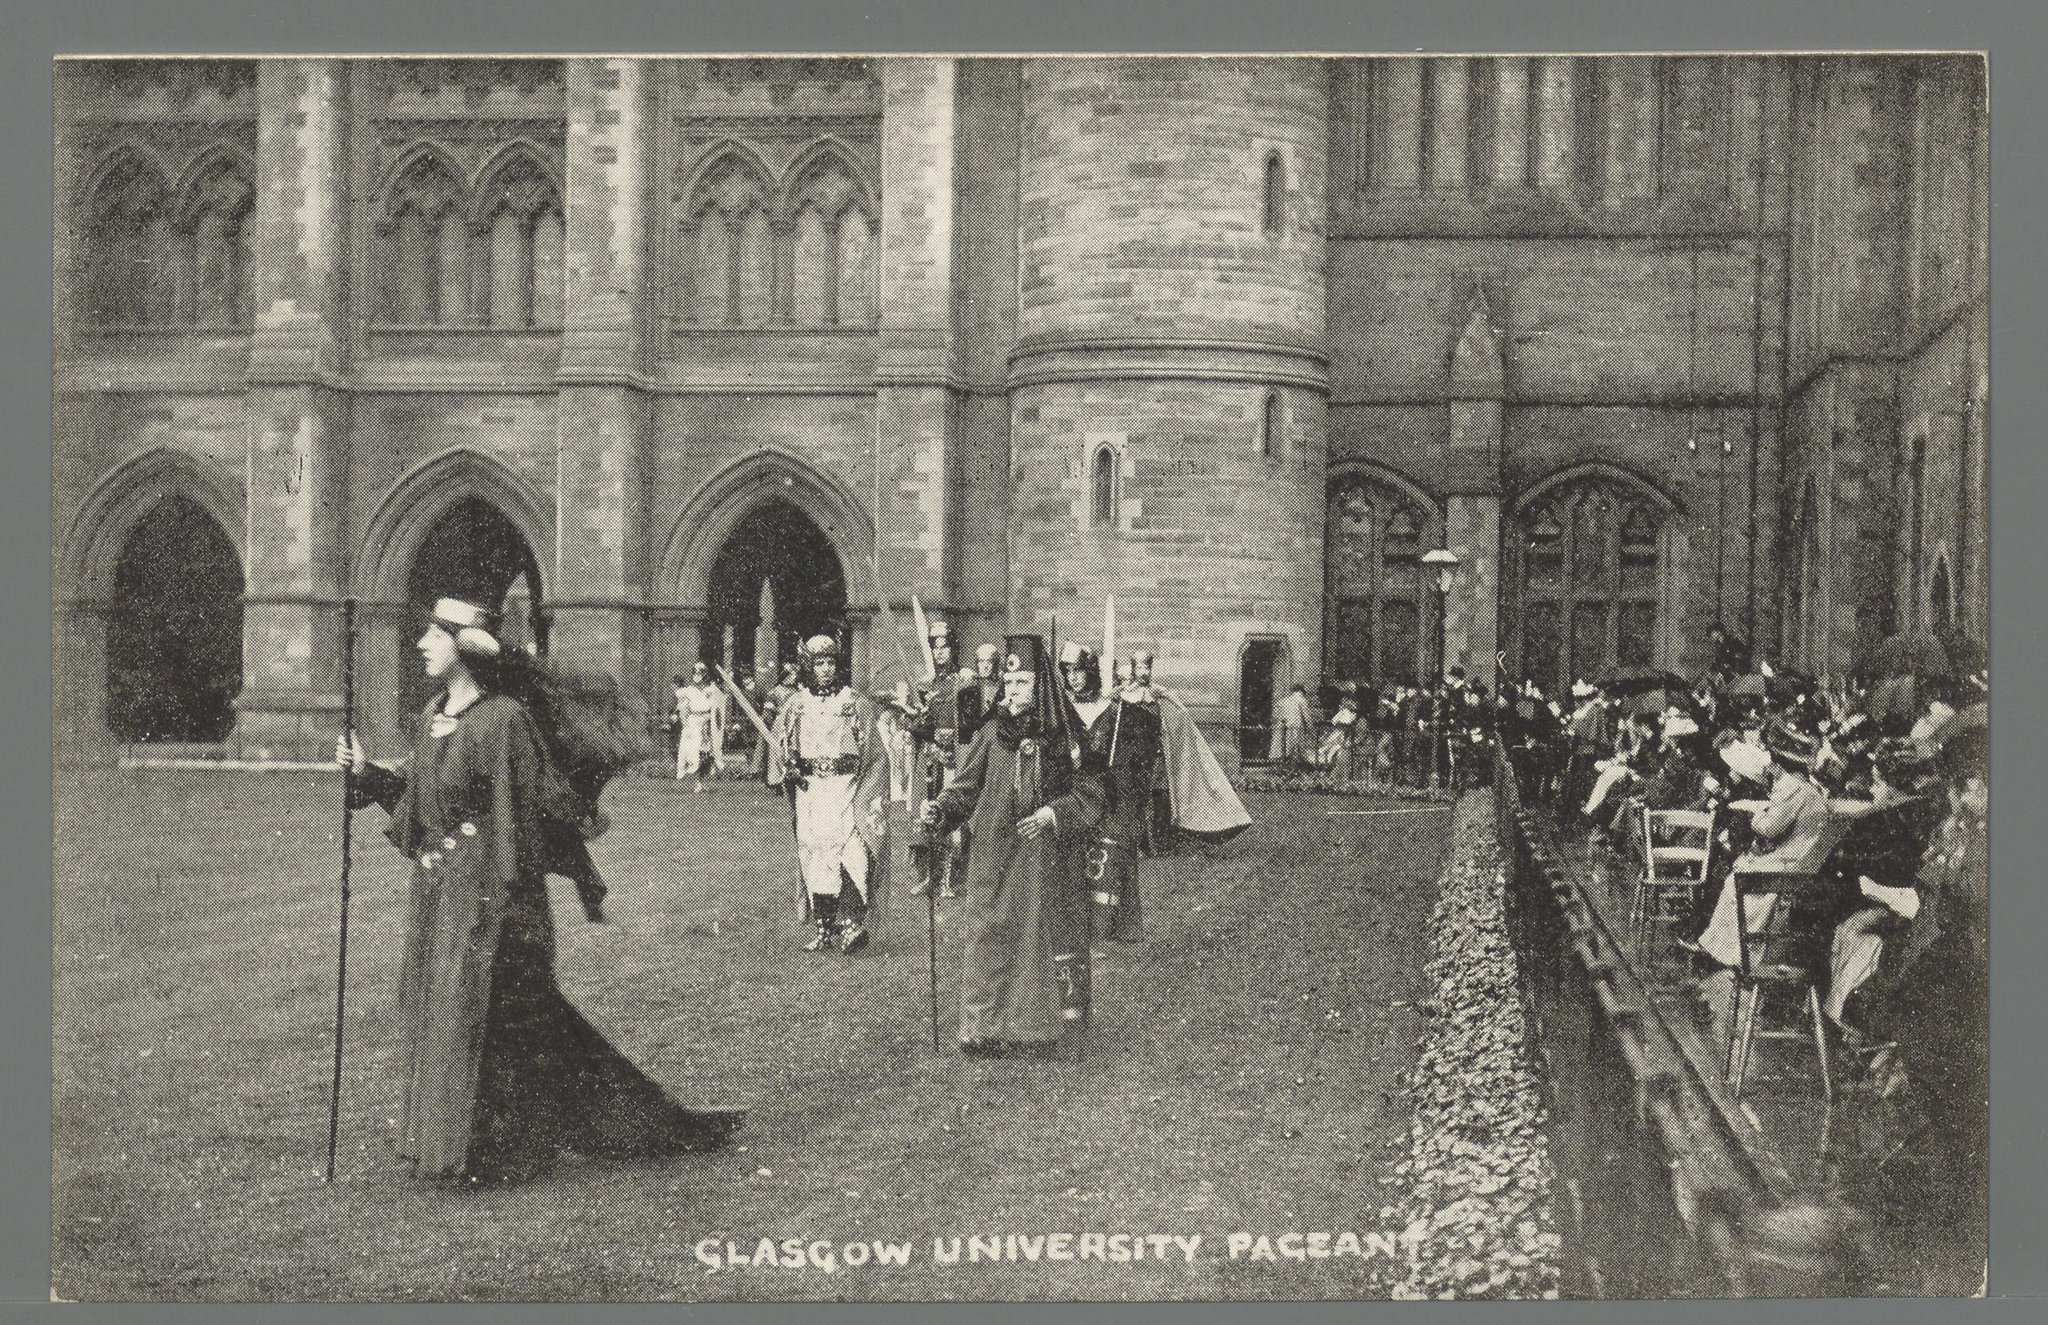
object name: photomechanical print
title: Glasgow University Pageant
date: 1903-1918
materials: cardboard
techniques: autotype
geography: great britain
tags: students' pageant, university building, college, glasgow